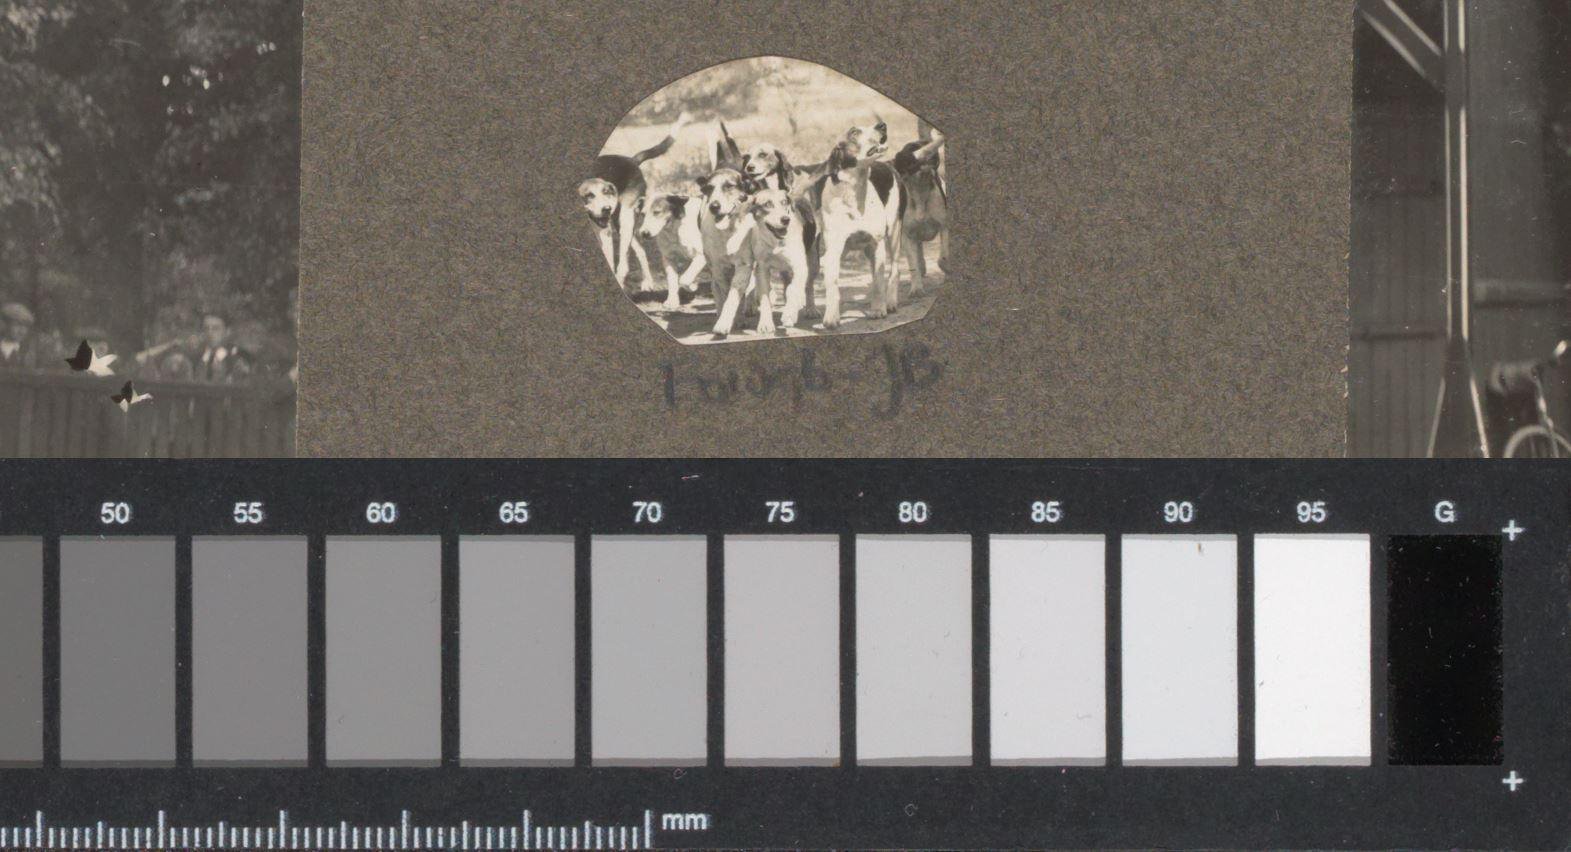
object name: album leaf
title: Ruitertafereel op Koninklijke Houtvesterij Het Loo: meute honden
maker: Anonymous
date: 1900-1925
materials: photographic support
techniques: gelatin silver print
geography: het loo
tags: hunting, chase, hunting dogs, hunting-ground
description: Onderdeel van Fotoalbum van de heer Brams, opperhoutvester van koningin Wilhelmina op Koninklijke Houtvesterij Het Loo.